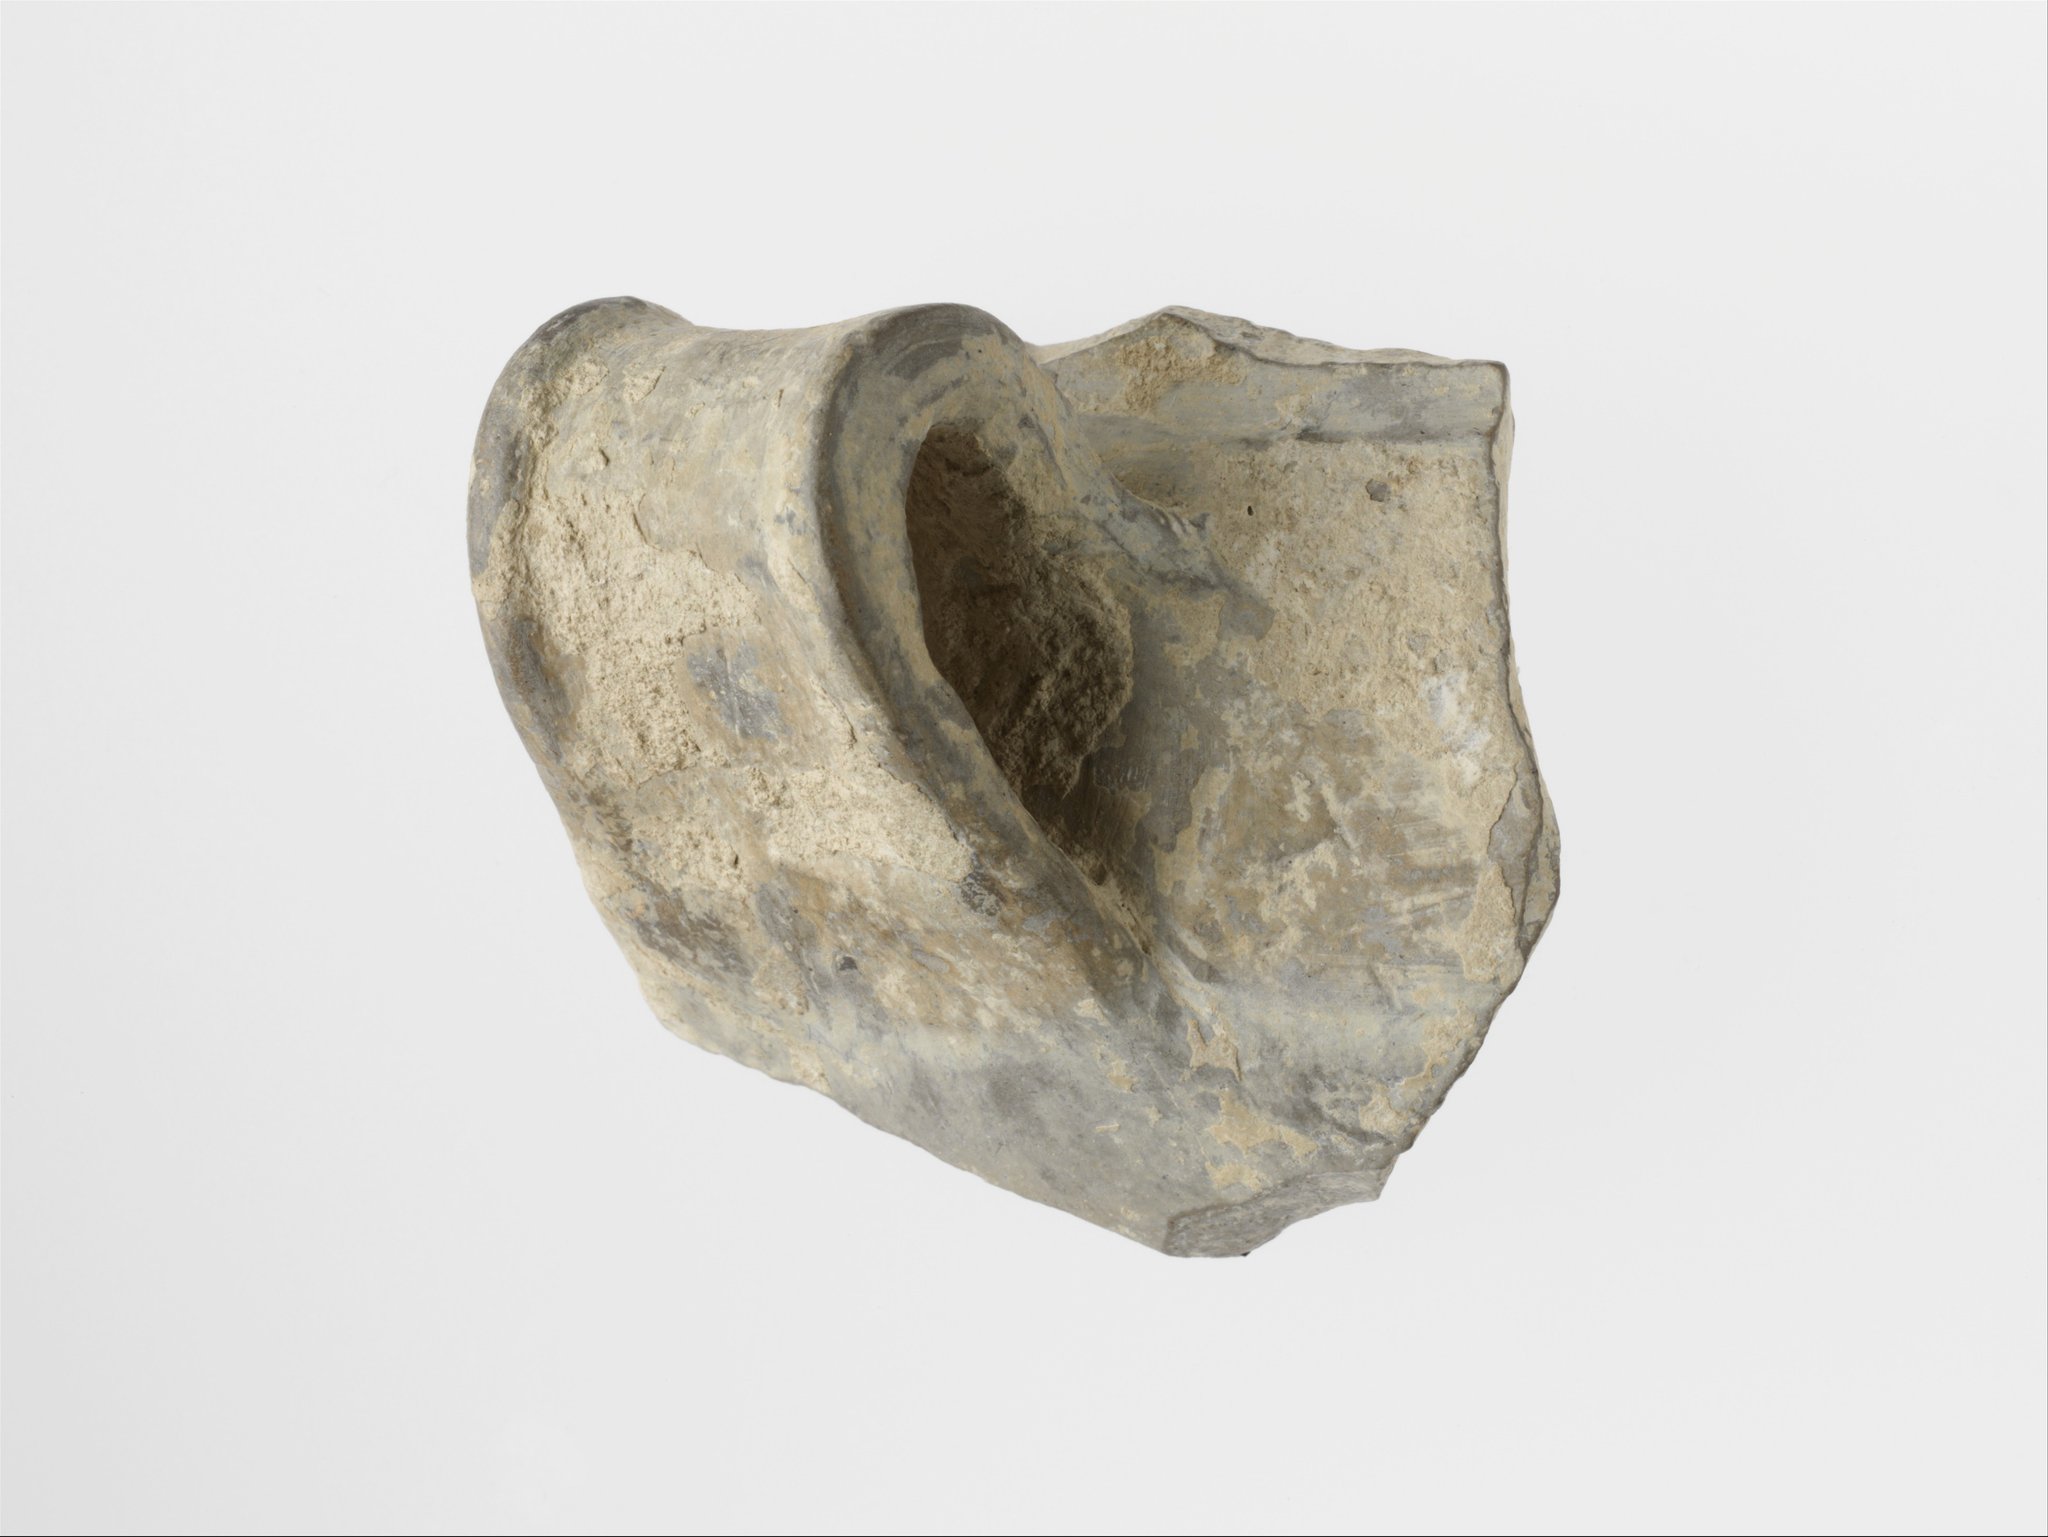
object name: vase fragment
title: Terracotta rim and handle of a vase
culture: helladic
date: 2000-1550 BCE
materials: terracotta